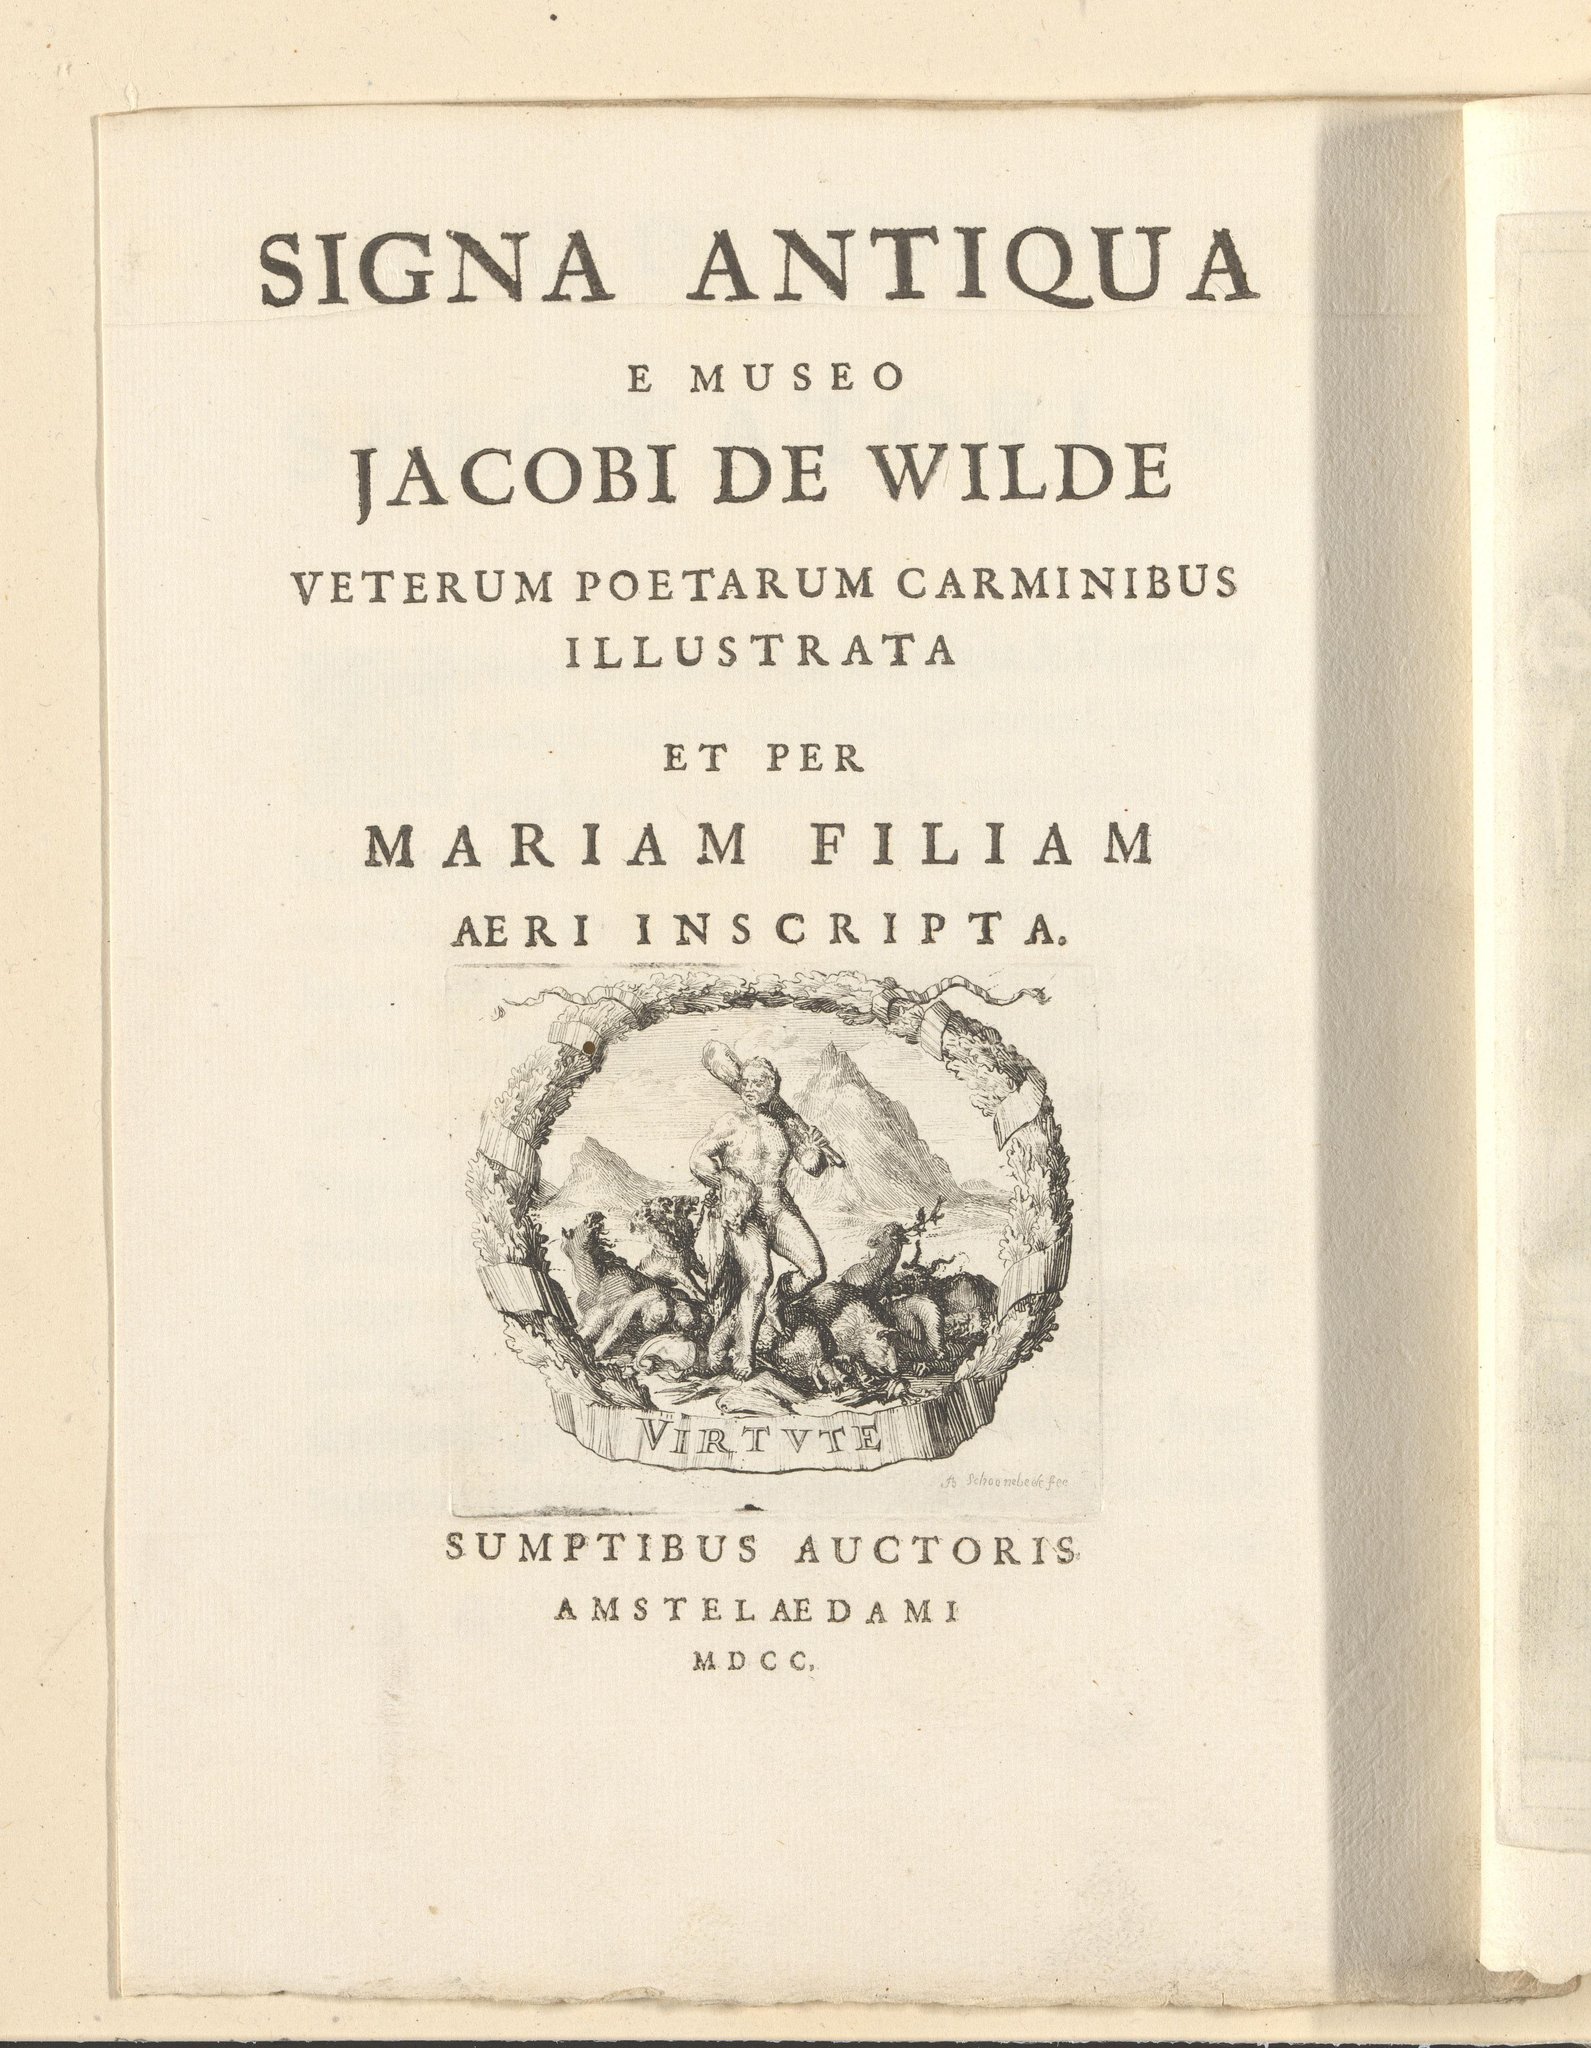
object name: titelblad, titelpagina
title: Vignet met Hercules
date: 1700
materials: paper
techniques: etching, letterpress printing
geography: amsterdam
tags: (story of) hercules (heracles), title-page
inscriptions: collector's mark: Lugt 2760, collector's mark: Lugt 2228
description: Titelpagina voor: Wilde, Maria de. Signa antiqua, e museo Jacobi de Wilde per Mariam filiam aeri inscripta, Amsterdam: Maria de Wilde, 1700